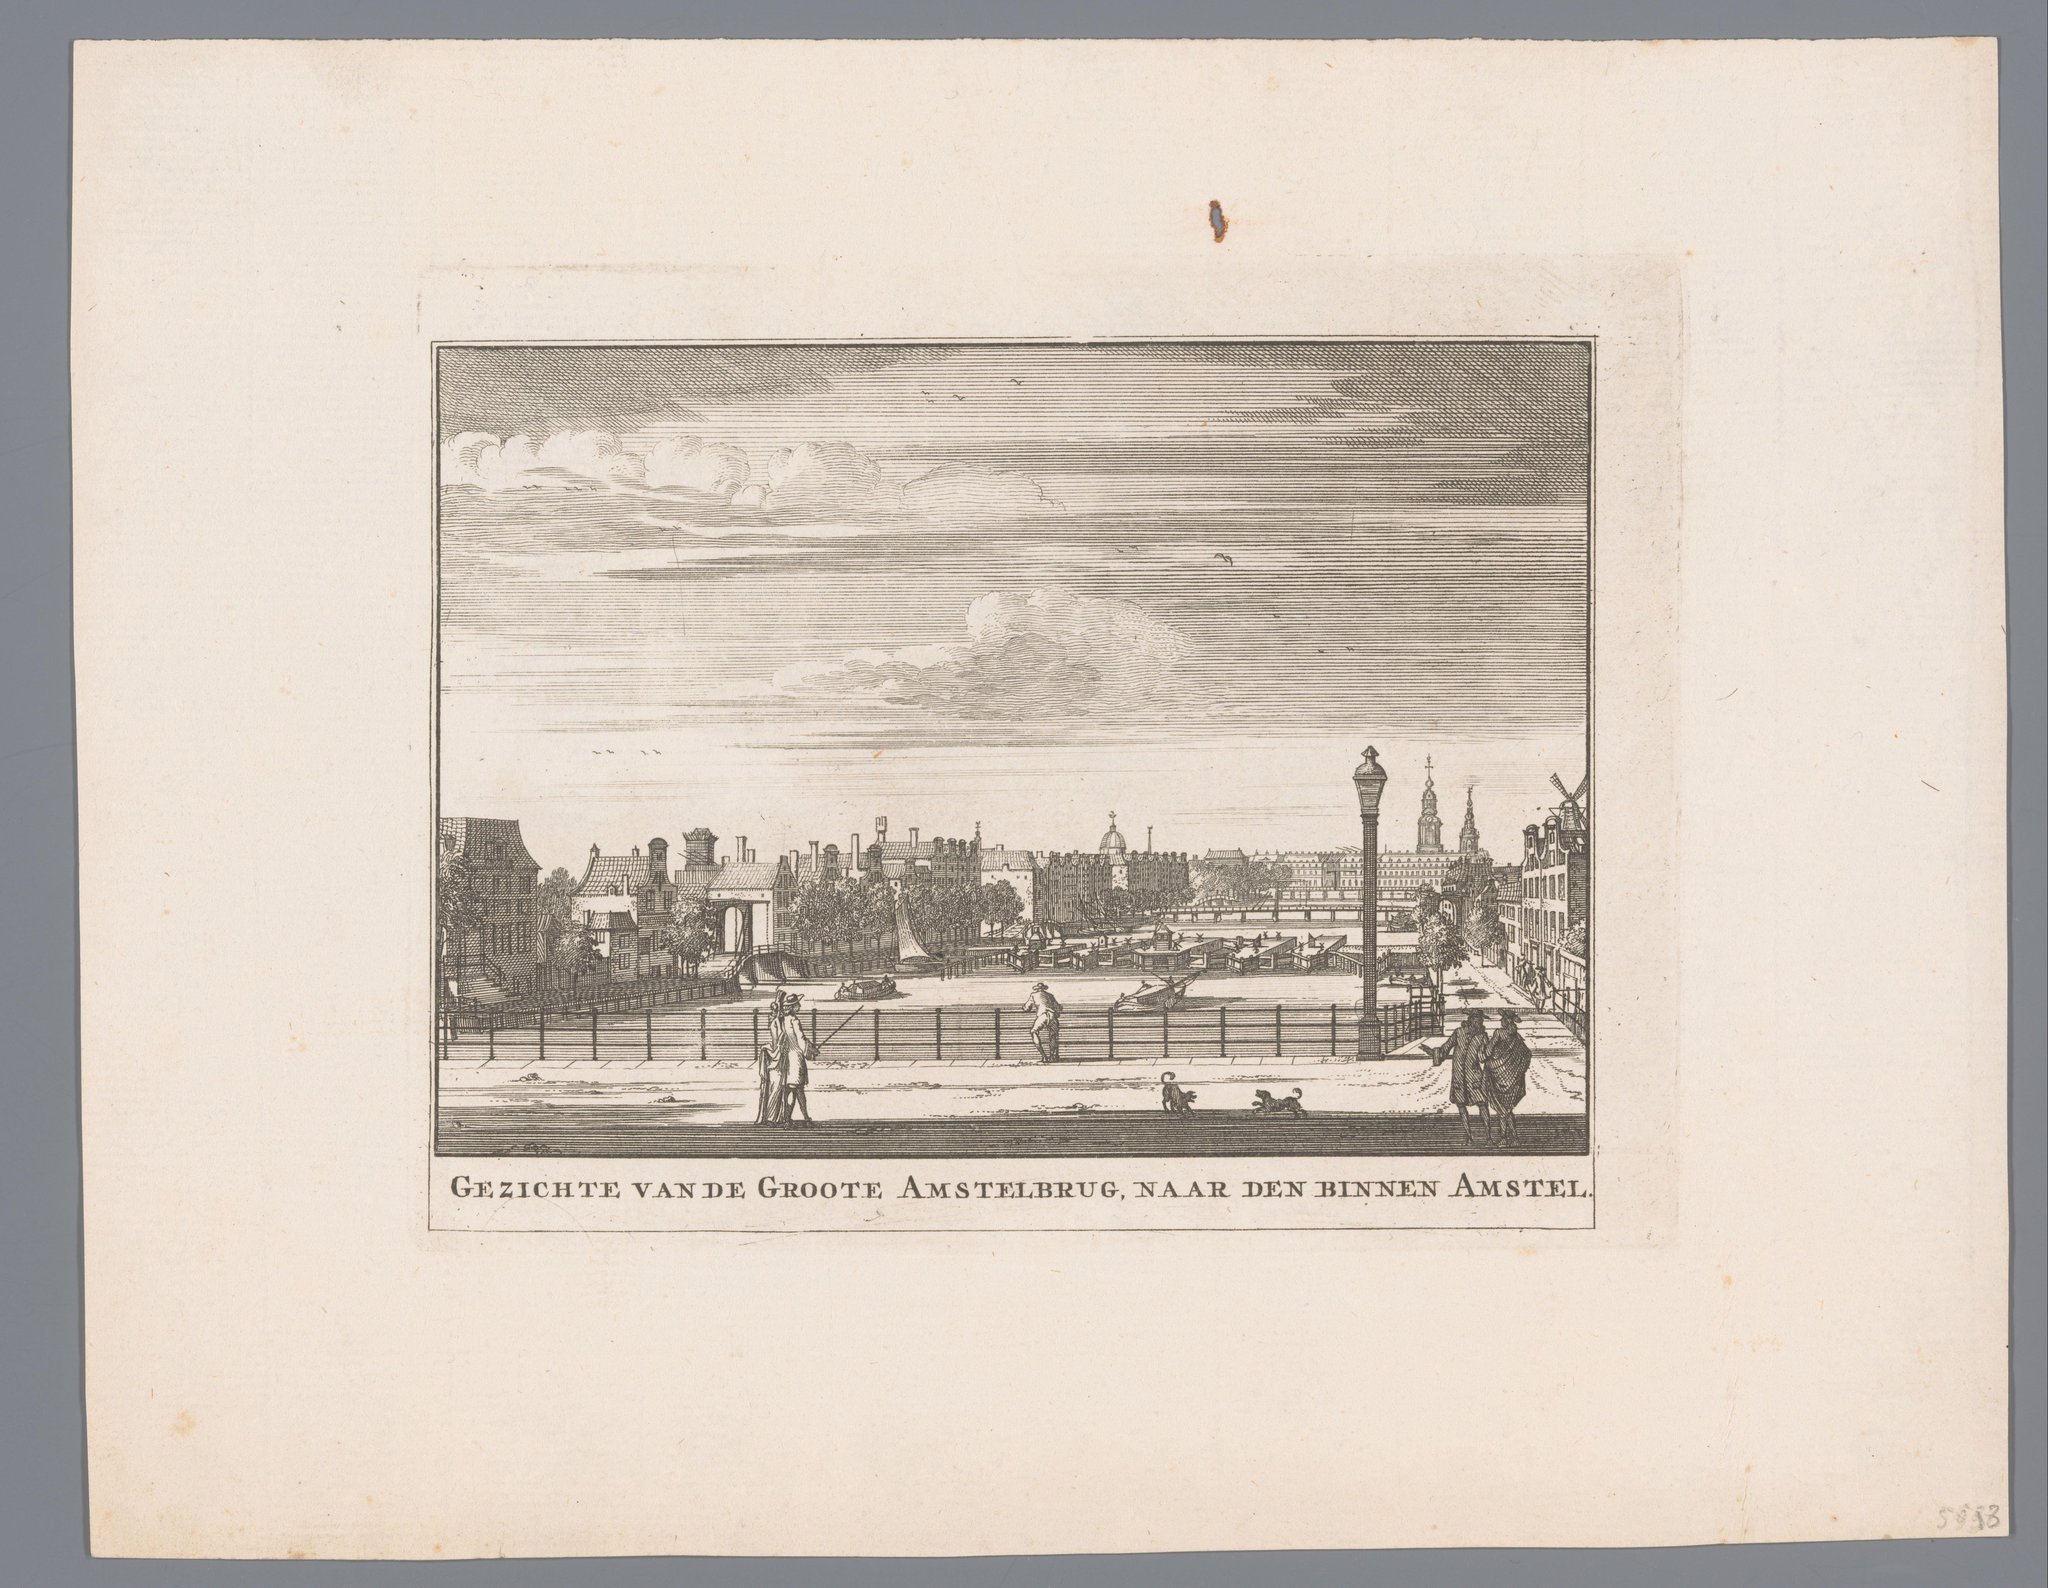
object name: print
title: Gezichte van de Groote Amstelbrug, naar den Binnen Amstel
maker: Anonymous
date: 1670-1730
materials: paper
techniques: etching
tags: city-view, and landscape with man-made constructions, canals, waters (in city), bridge in city across river, canal, etc.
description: Tweede staat van prent genummerd 59 gebruikt in: Hoorn, Nicolaas ten. Wegwyzer door Amsterdam zynde eene beknopte verhandeling van desselfs eerste opkomst, vergrootingen, en teegenwoordigen staat. Amsterdam: Nicolaas ten Hoorn, 1713. Derde staat van prent genummerd 64 gebruikt in: Hoorn, Nicolaas ten. Wegwyzer door Amsterdam, Zynde eene beknopte verhandeling van desselfs eerste opkomst, vergrootingen, en teegenwoordigen staat (…). Tweede druk. Amsterdam: Nicolaas ten Hoorn, 1726, p. 65. En in de latere edities (Amsterdam: erven J. Ratelband & Co, 1737, en Amsterdam: Pieter Meyer, 1751).